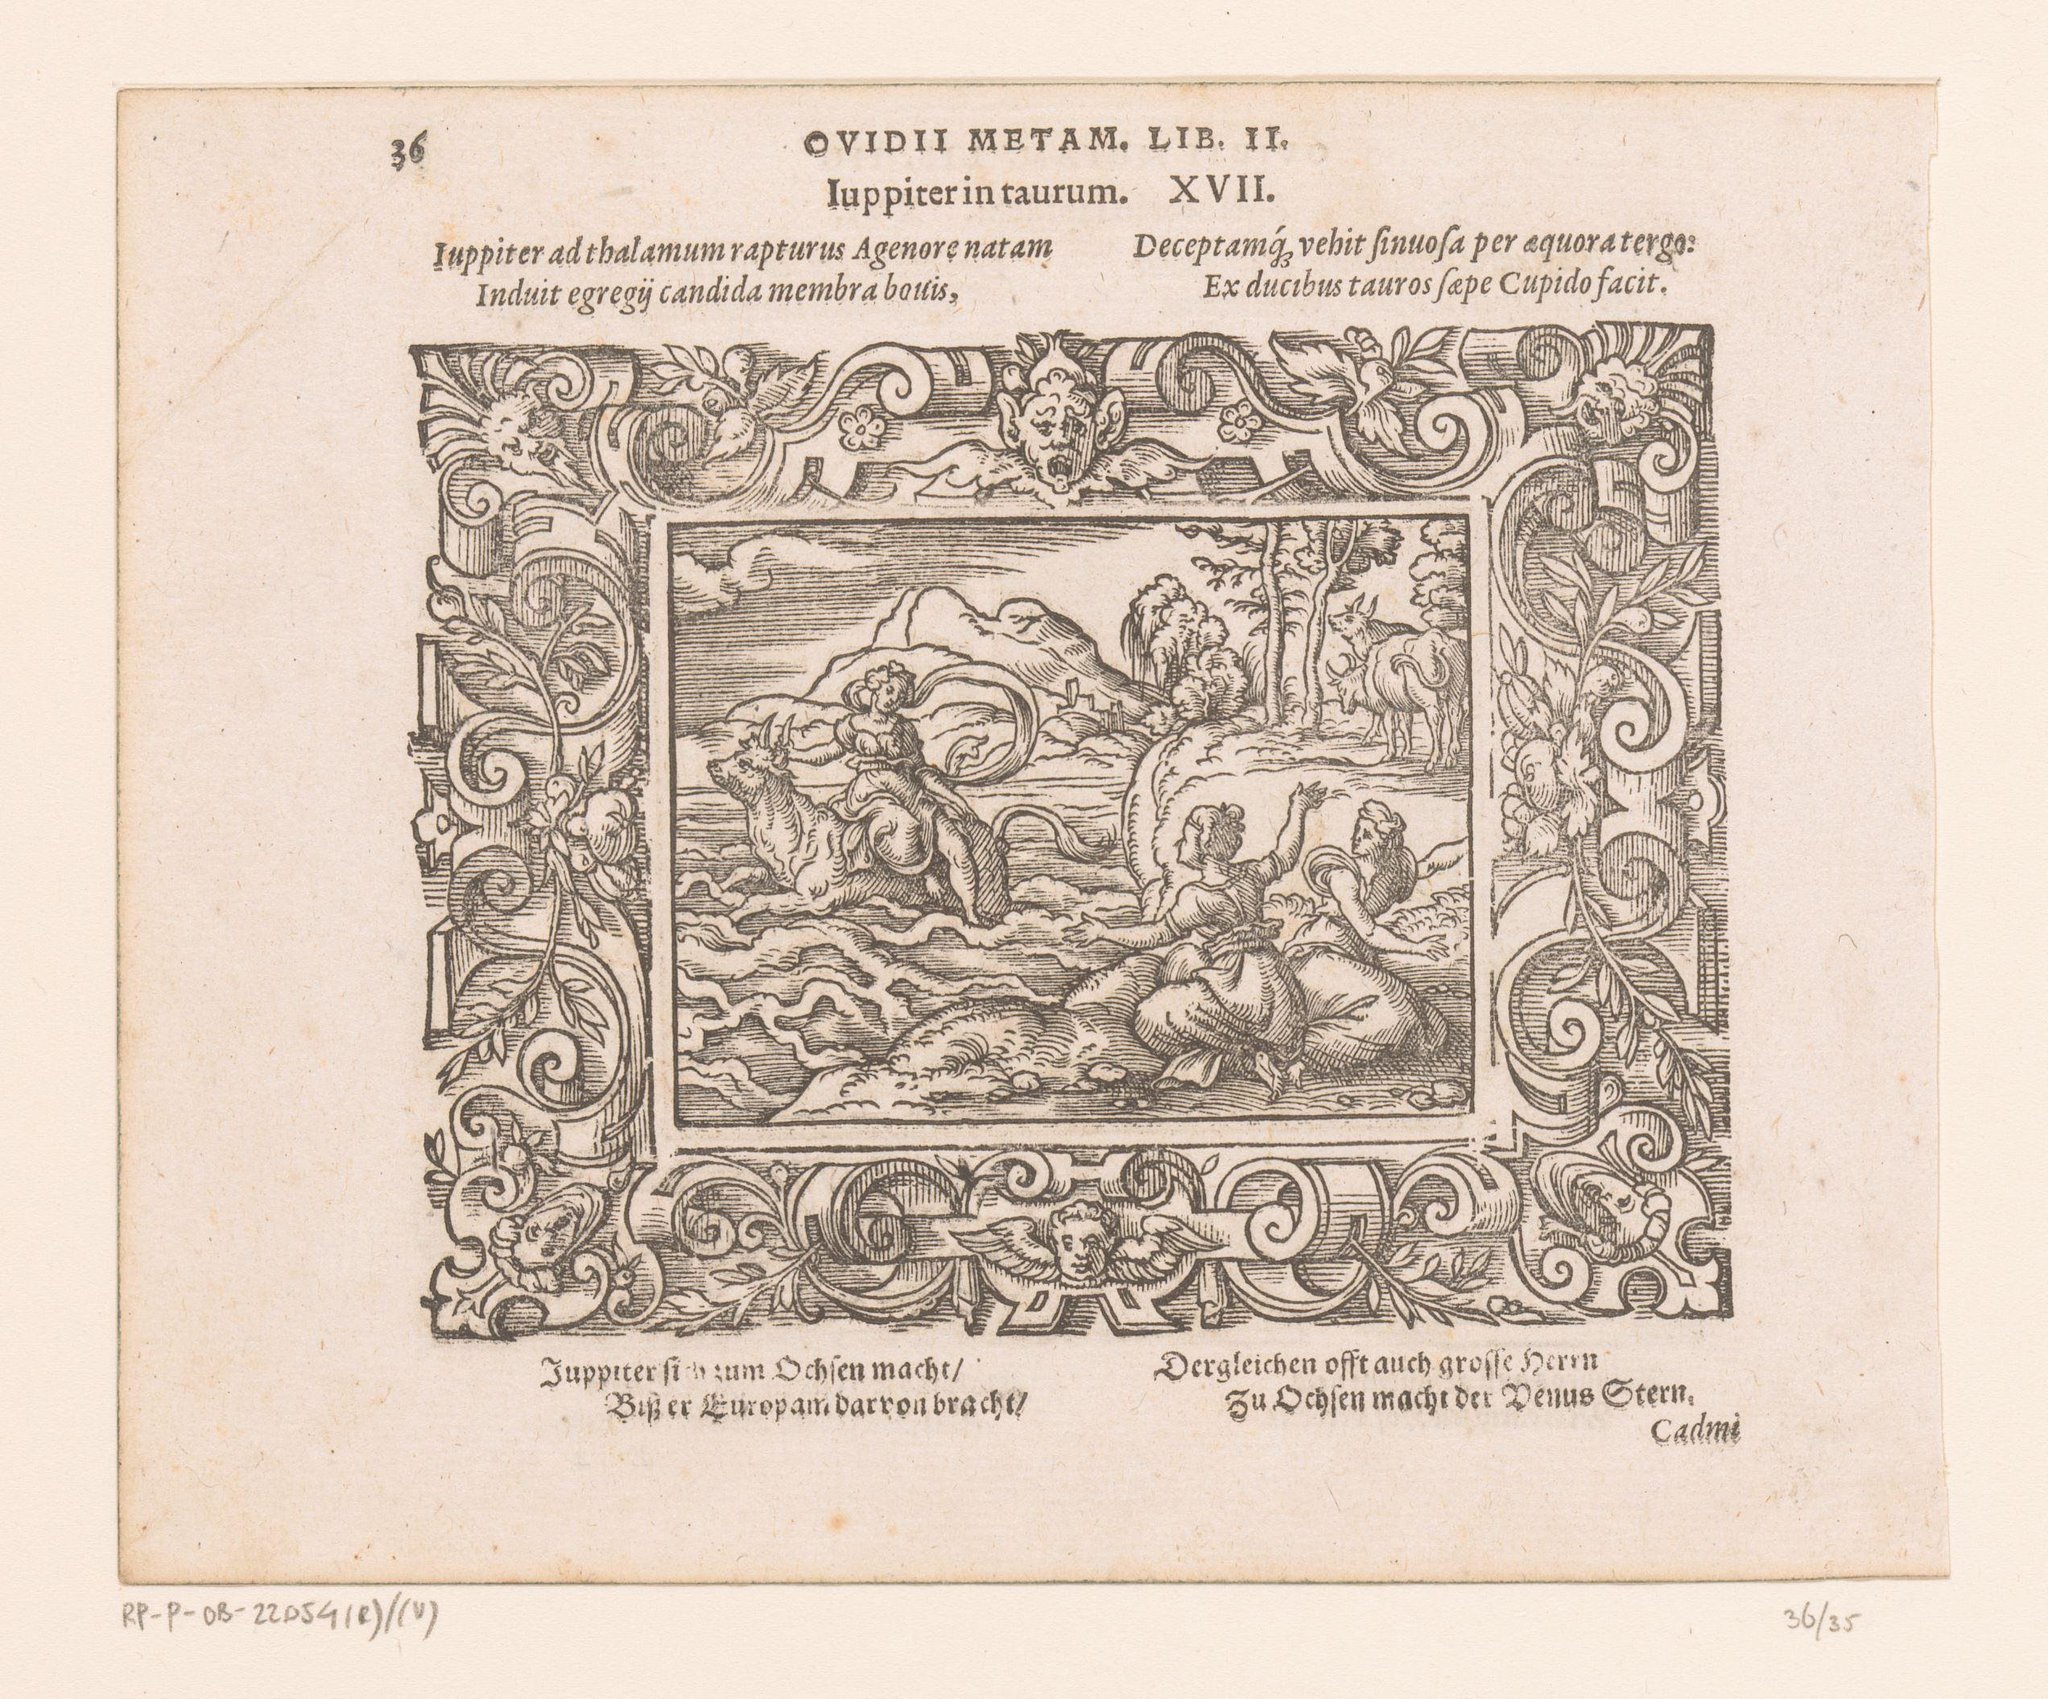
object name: print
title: Iuppiter in taurum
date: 1569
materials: paper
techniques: letterpress printing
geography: frankfurt am main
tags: jupiter, usually in the shape of a white bull, abducts europa and carries her across the water, scrollwork, strapwork ~ ornament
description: Illustratie bij de Metamorfosen van Ovidius, afkomstig uit de publicatie: Posthius, Johannes. Tetrasticha in Ovidii metam. Frankfurt am Main: Georg Rab en Sigmund Feyerabend en erven Weigand Han, 1569. De voorstellingen en ornamentranden van deze boekillustraties zijn van twee aparte blokken gedrukt. Beide werden afzonderlijk van elkaar ook gebruikt voor andere publicaties, en de ornamentranden werden eveneens binnen deze publicatie meerdere keren gebruikt.